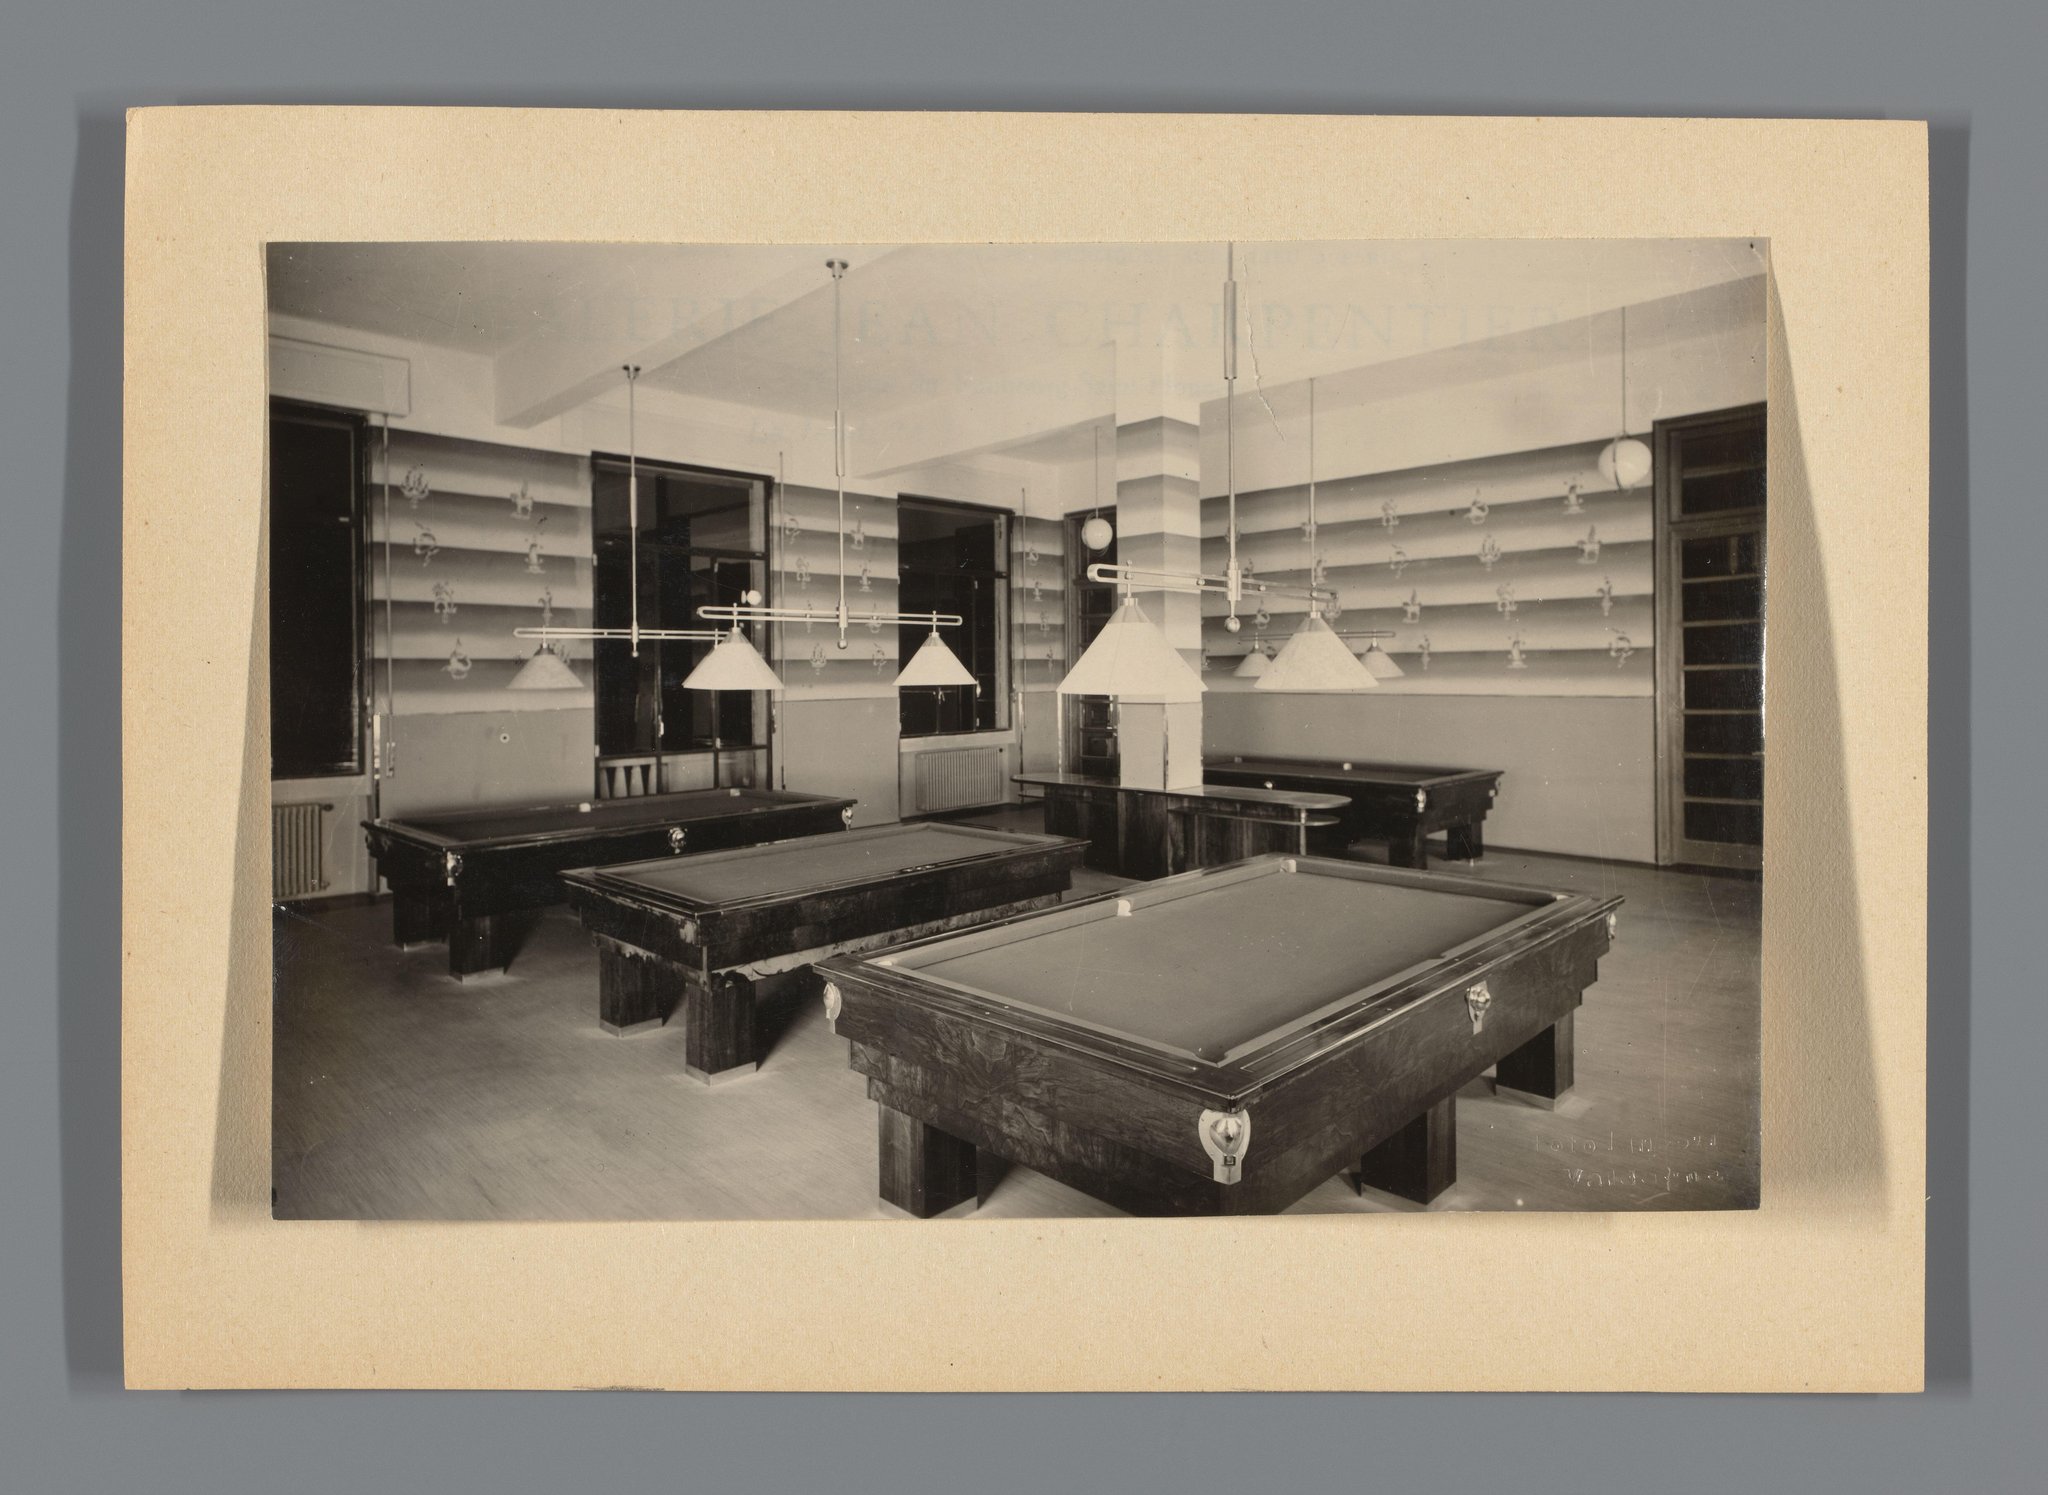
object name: photograph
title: Italië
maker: Anonymous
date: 1880-1910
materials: photographic support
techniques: albumen print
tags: italy